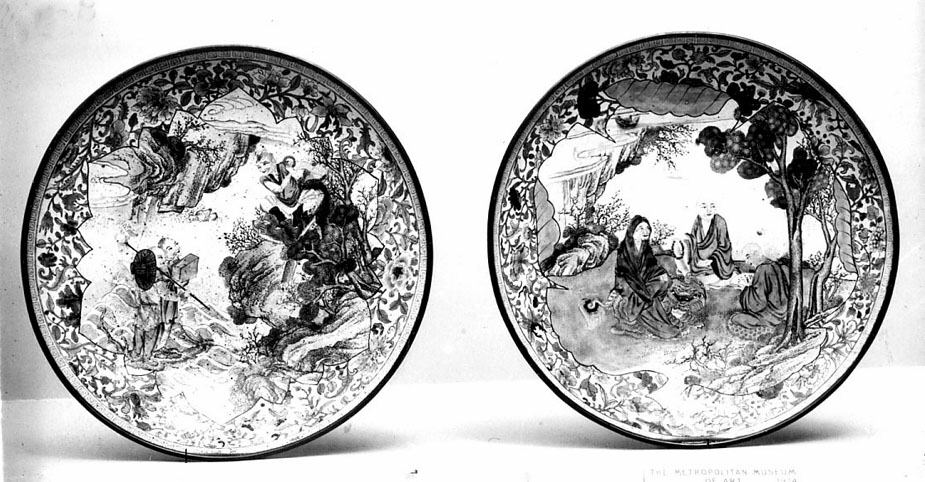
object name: dish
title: Dish (one of a pair)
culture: chinese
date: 1736-1795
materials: enamel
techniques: painting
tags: men,trees